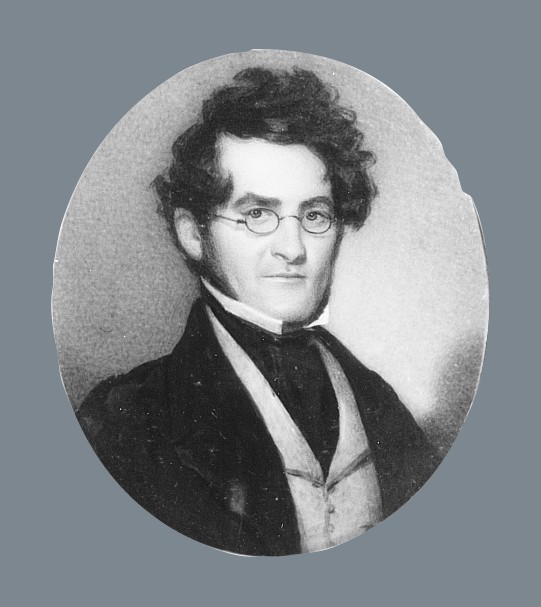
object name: painting, miniature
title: Portrait of a Gentleman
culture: american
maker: john wood dodge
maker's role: artist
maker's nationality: american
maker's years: 1807-1893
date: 1841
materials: ivory, watercolor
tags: men,portraits